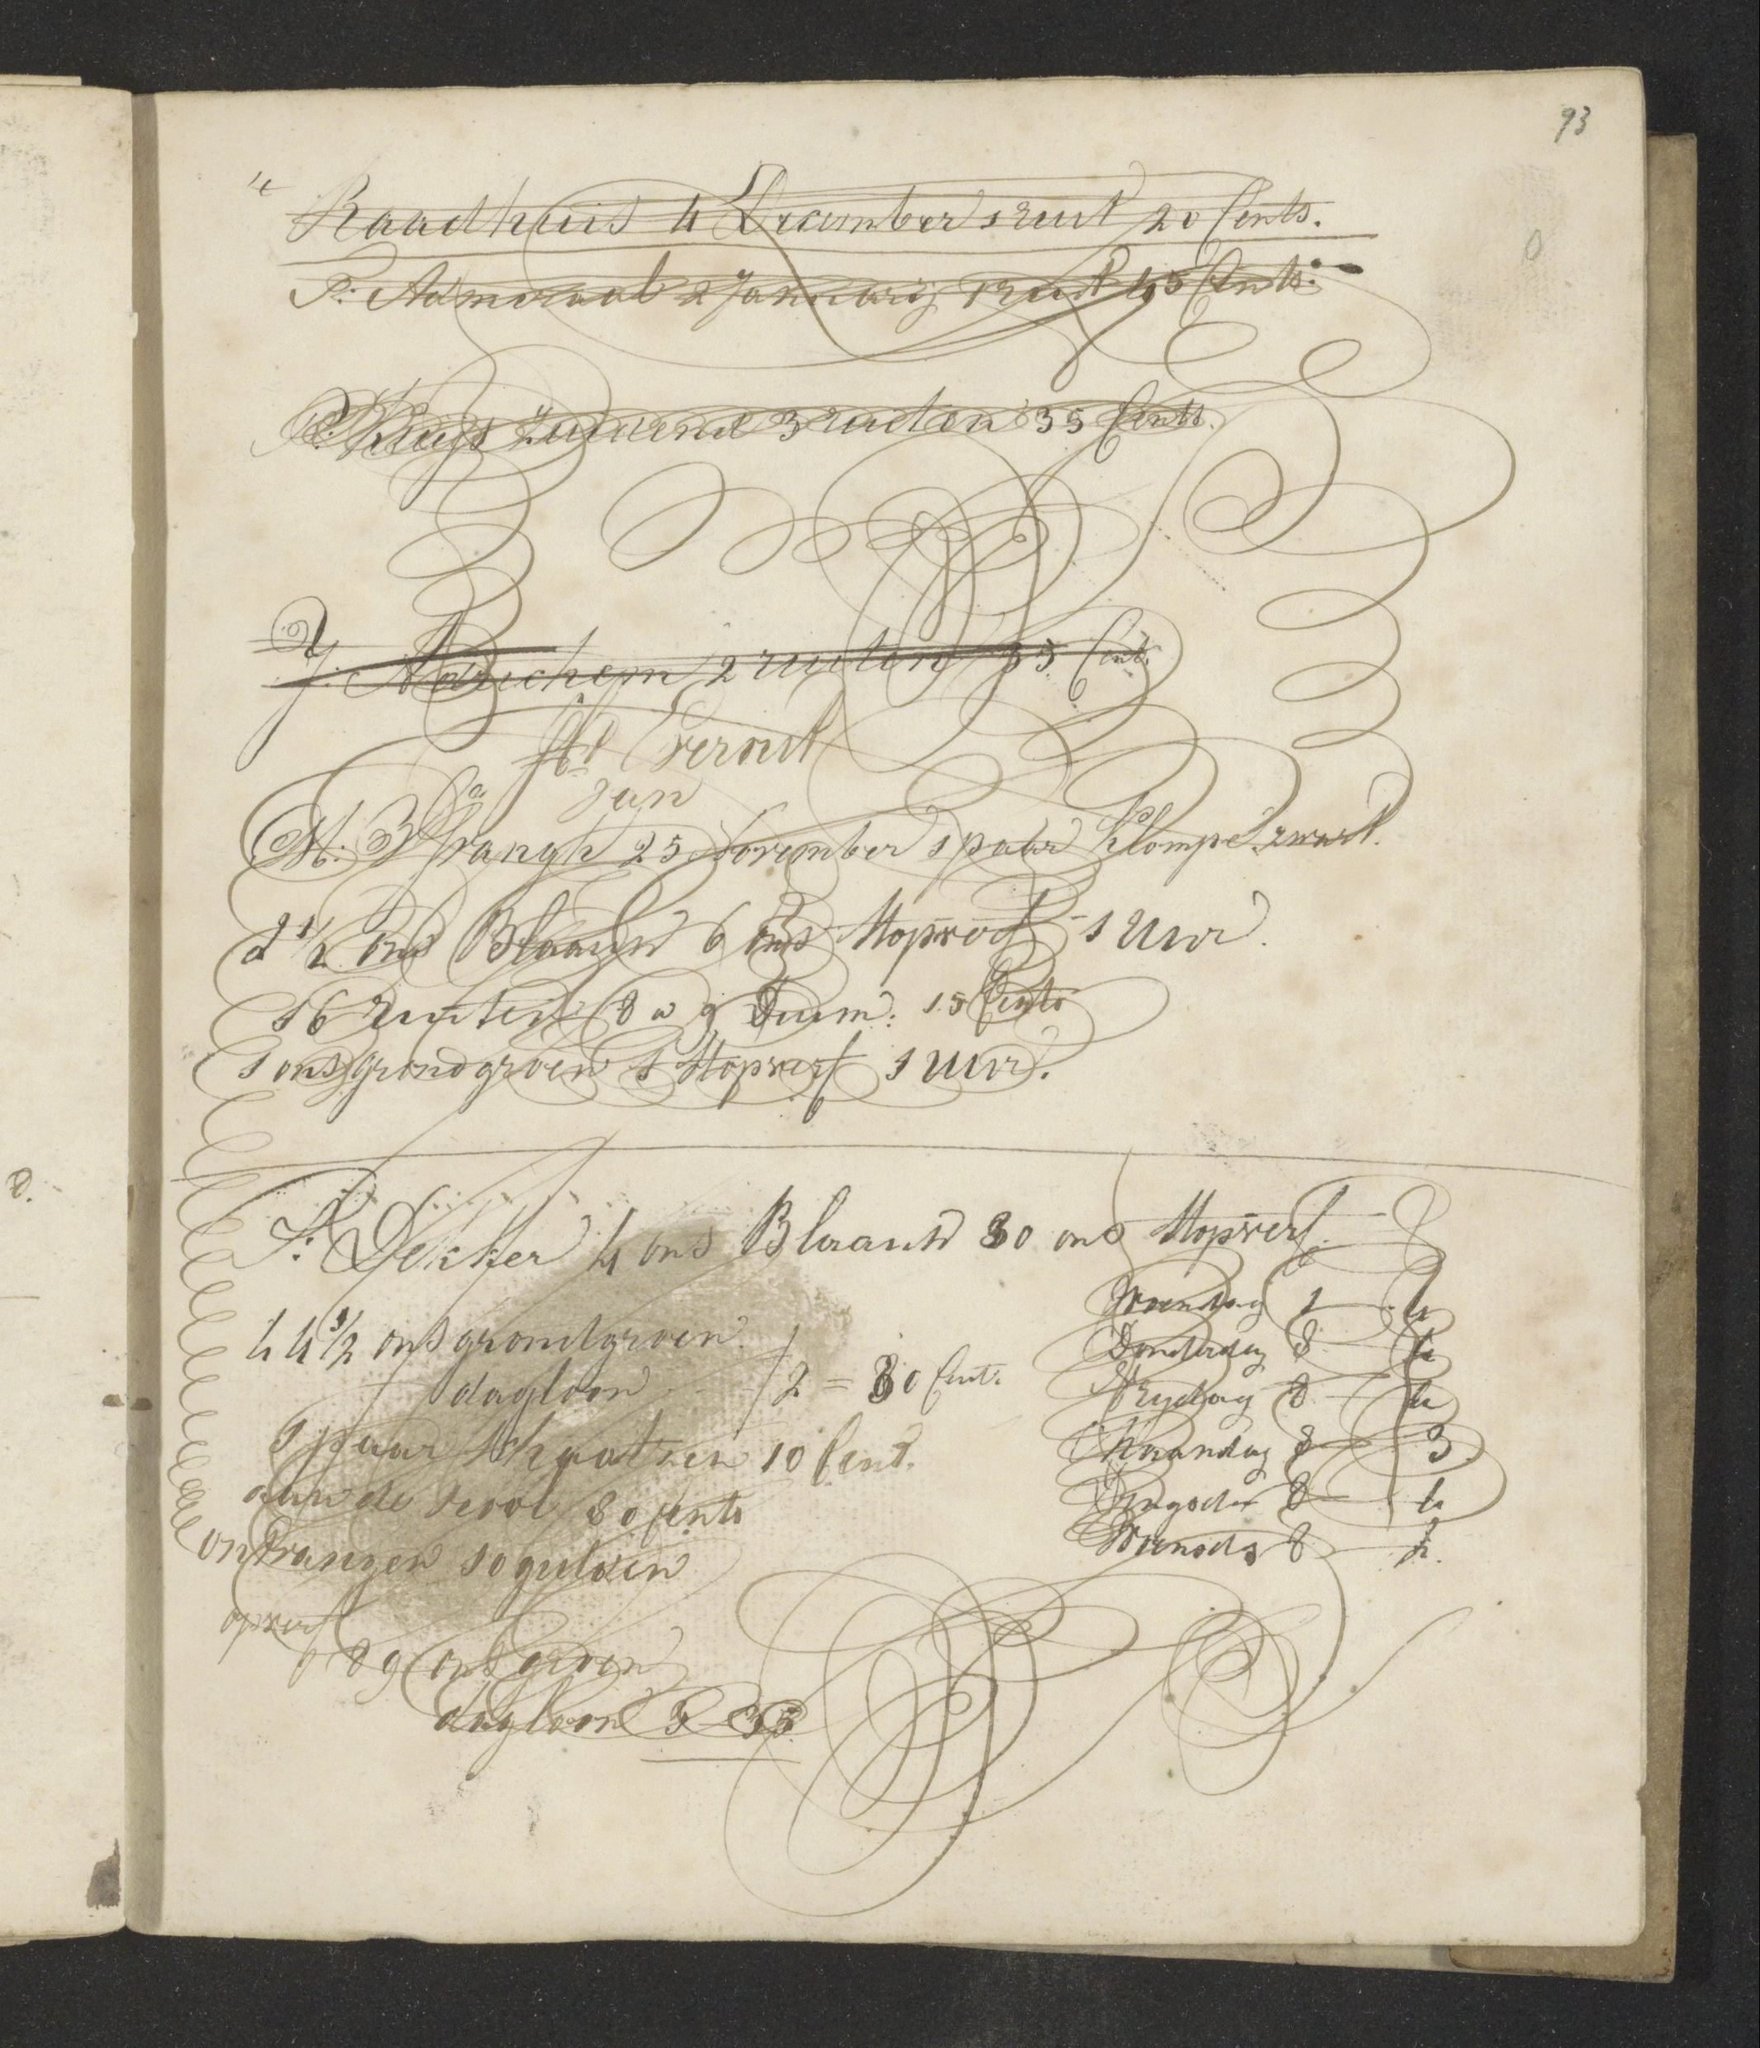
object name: sketchbook leaf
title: Kasboek met notities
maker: Anonymous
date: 1840-1860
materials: ink, paper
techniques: pen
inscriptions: annotation: ‘...’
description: Kasboek van een schilder met notities over aangeschafte materialen. Bladzijde 93 uit een schetsboek met 96 bladzijden.